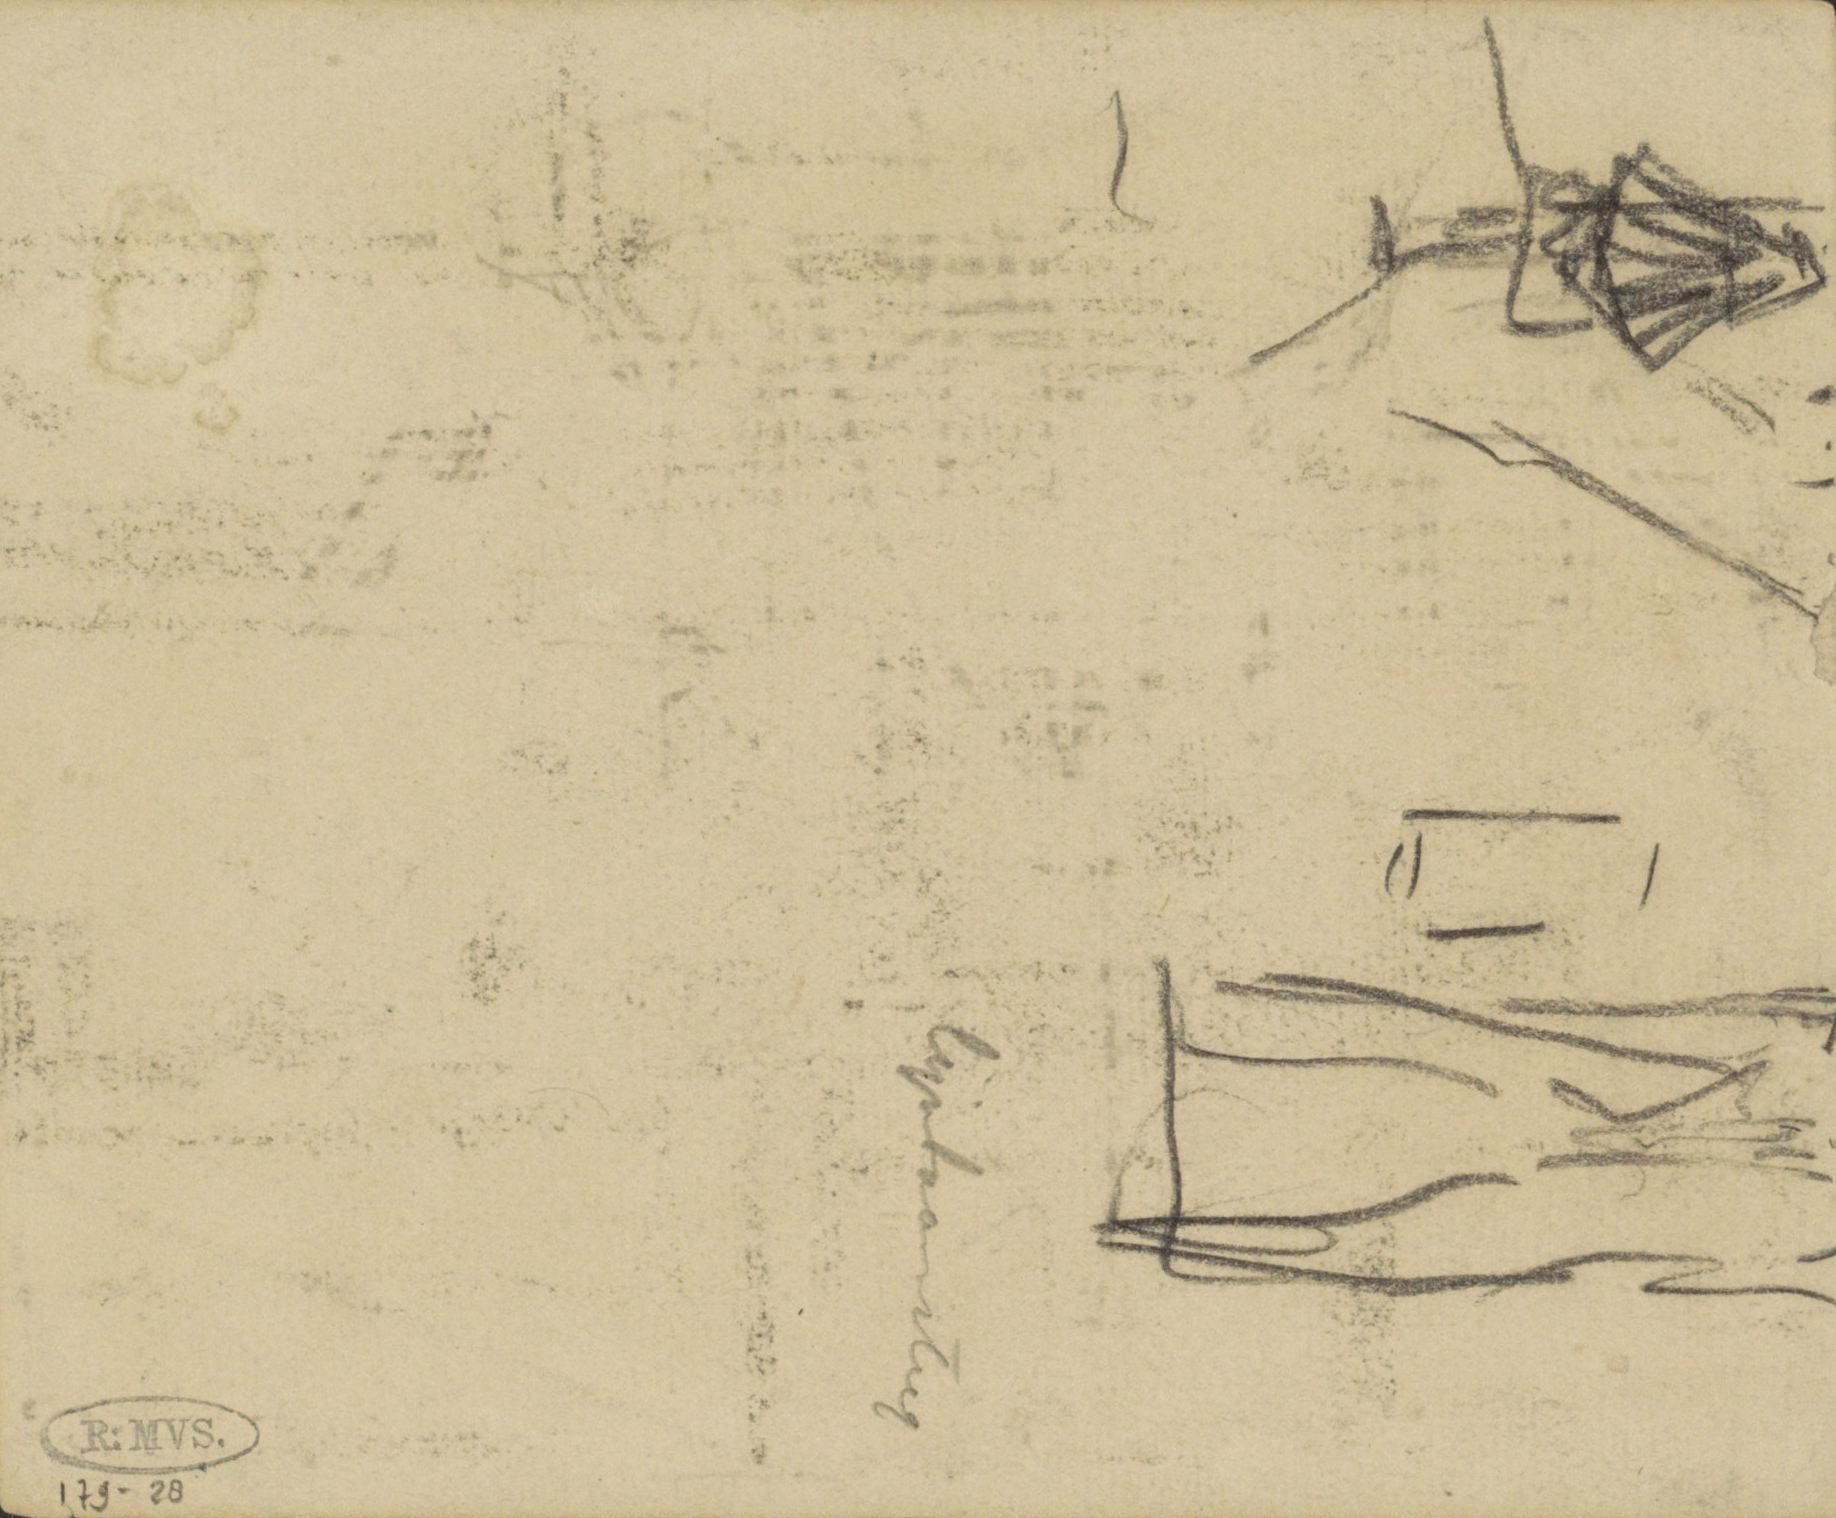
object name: drawing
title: Figuur- en architectuurstudies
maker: george hendrik breitner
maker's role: draughtsman, painter, print maker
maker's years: 1857-1923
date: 1886-1923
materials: chalk, paper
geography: amsterdam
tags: standing figure, civic architecture; edifices; dwellings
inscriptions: collector's mark: Lugt 2228, annotation: ‘lijnbaanssteeg’